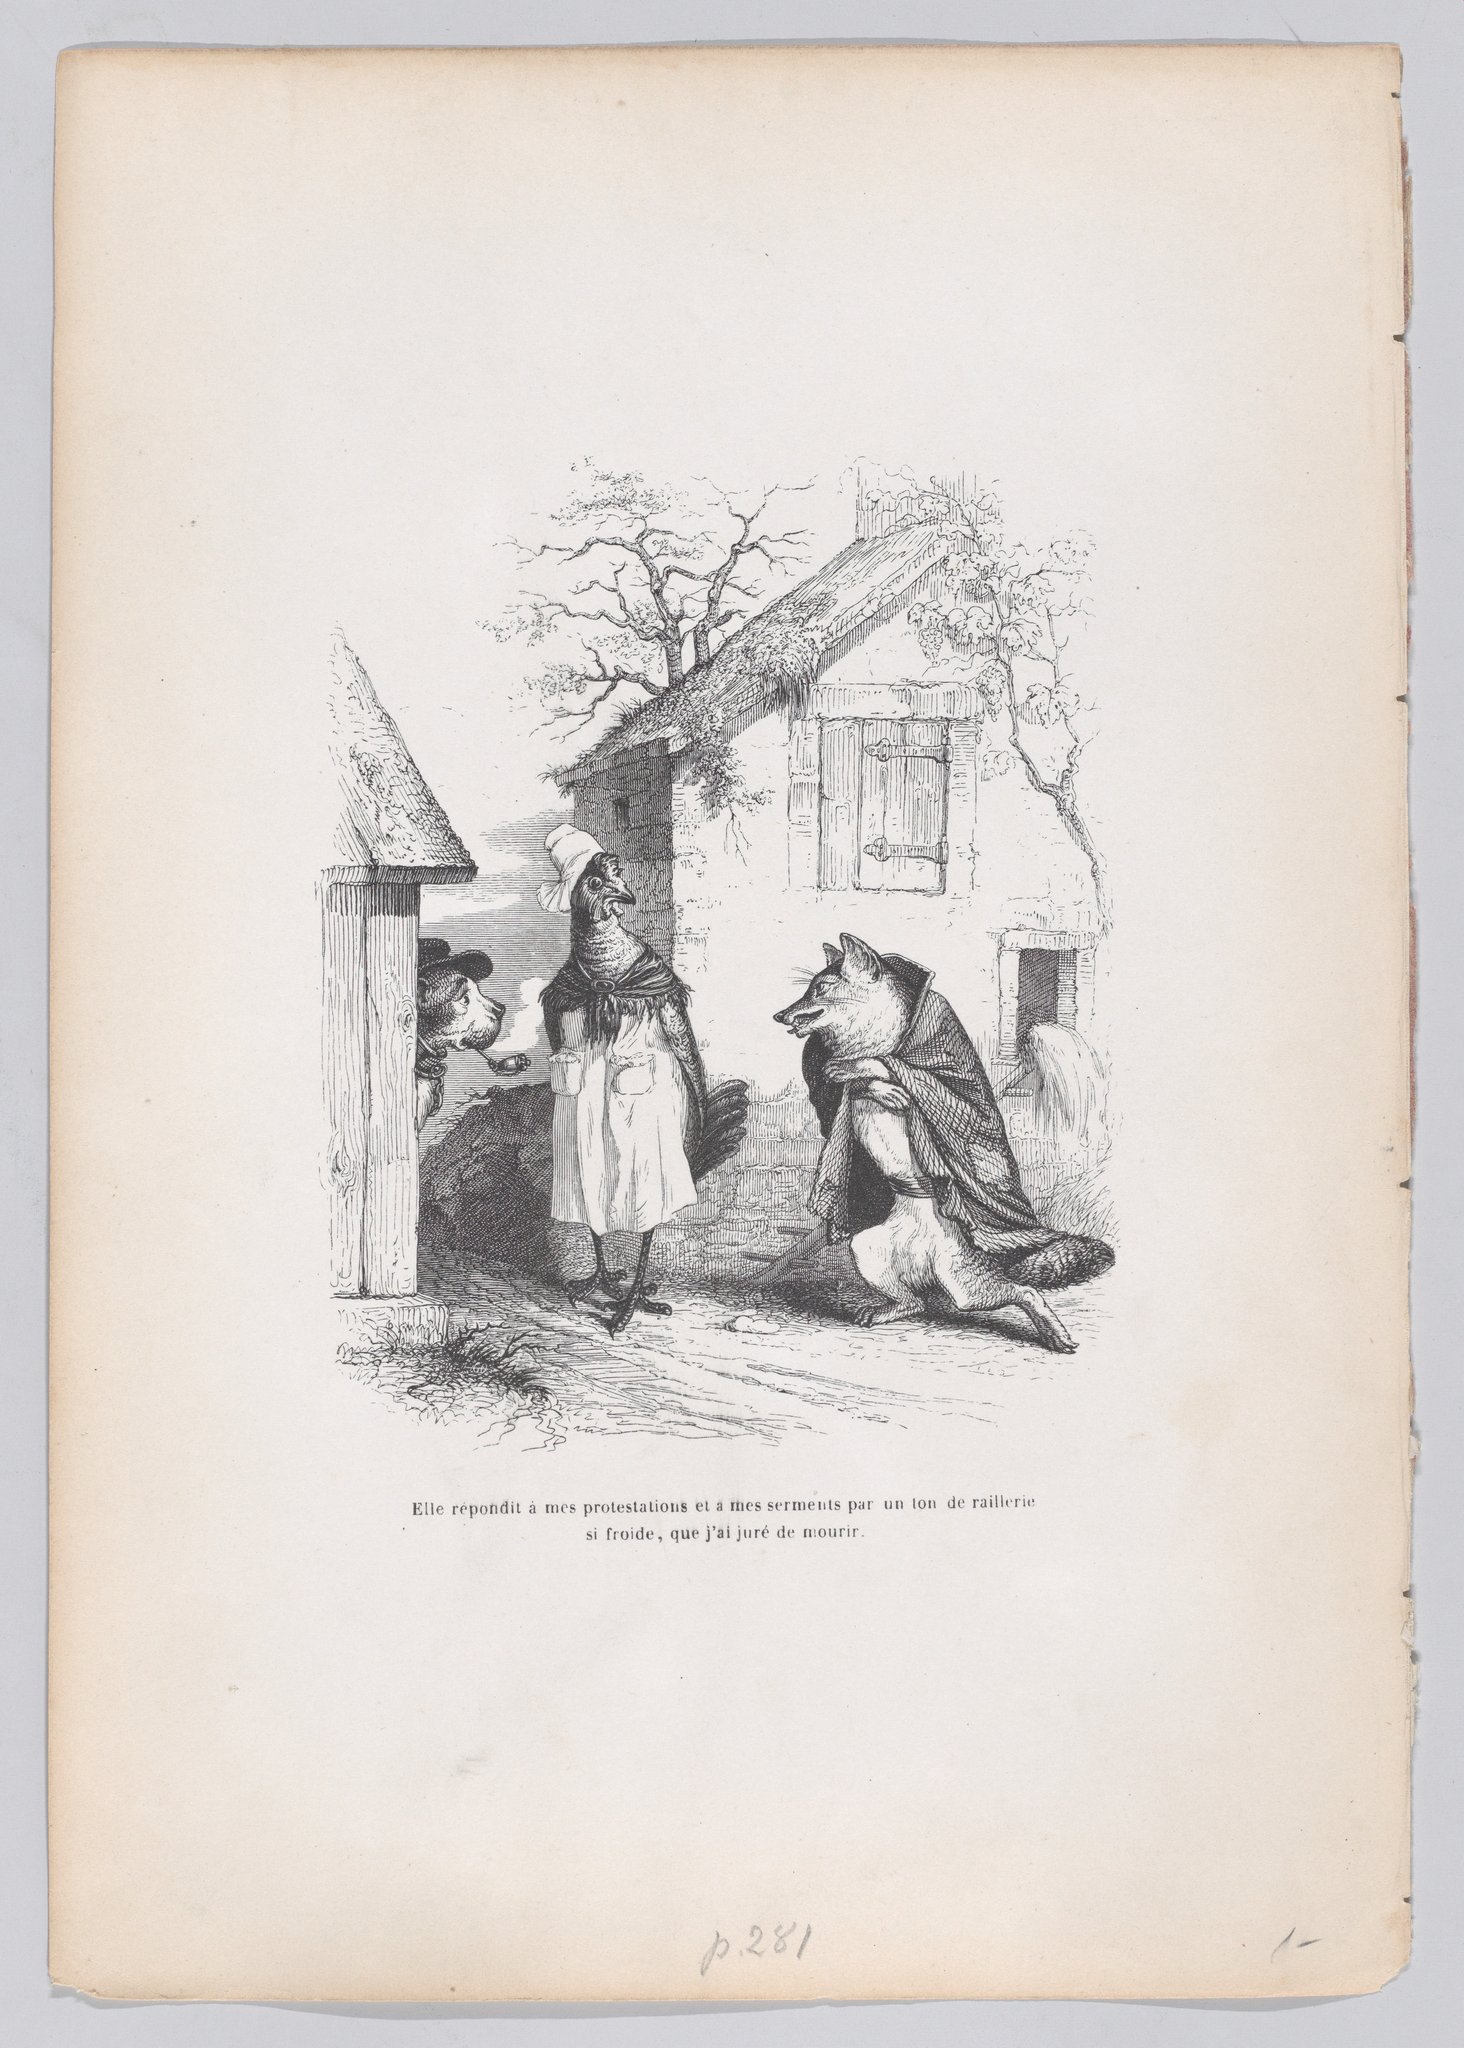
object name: print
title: She responded to my protests and oaths with a tone of mockery so cold that I swore to die, from "Scenes from the Private and Public Life of Animals"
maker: j. j. grandville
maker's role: artist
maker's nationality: french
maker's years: 1803-1847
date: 1837-1847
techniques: engraving